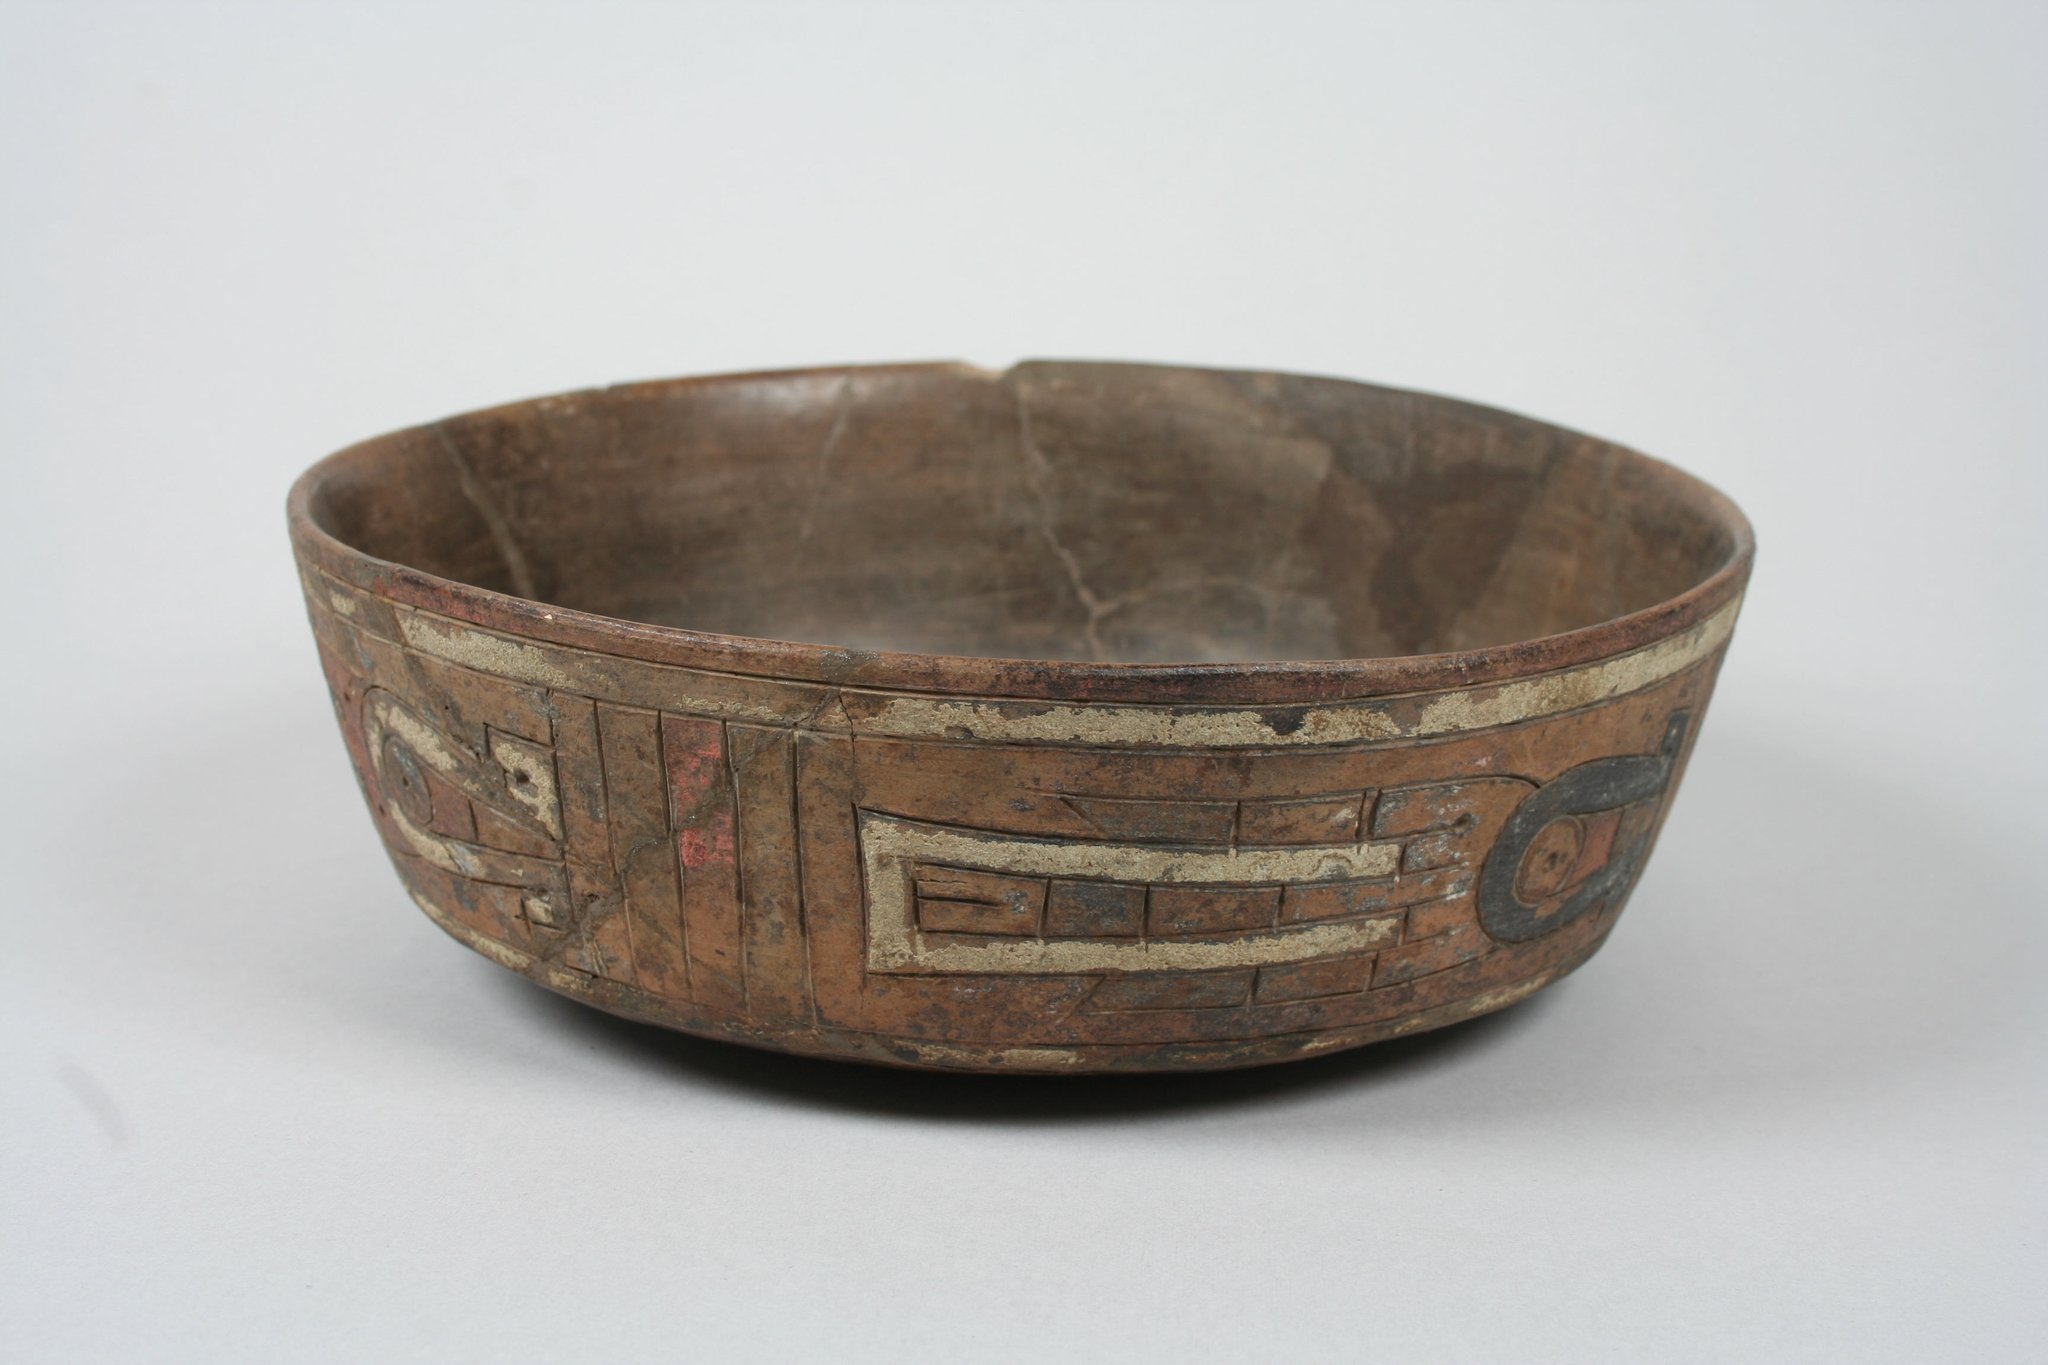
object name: bowl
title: Incised bowl with birds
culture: paracas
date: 700-401 BCE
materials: ceramic, pigment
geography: peru